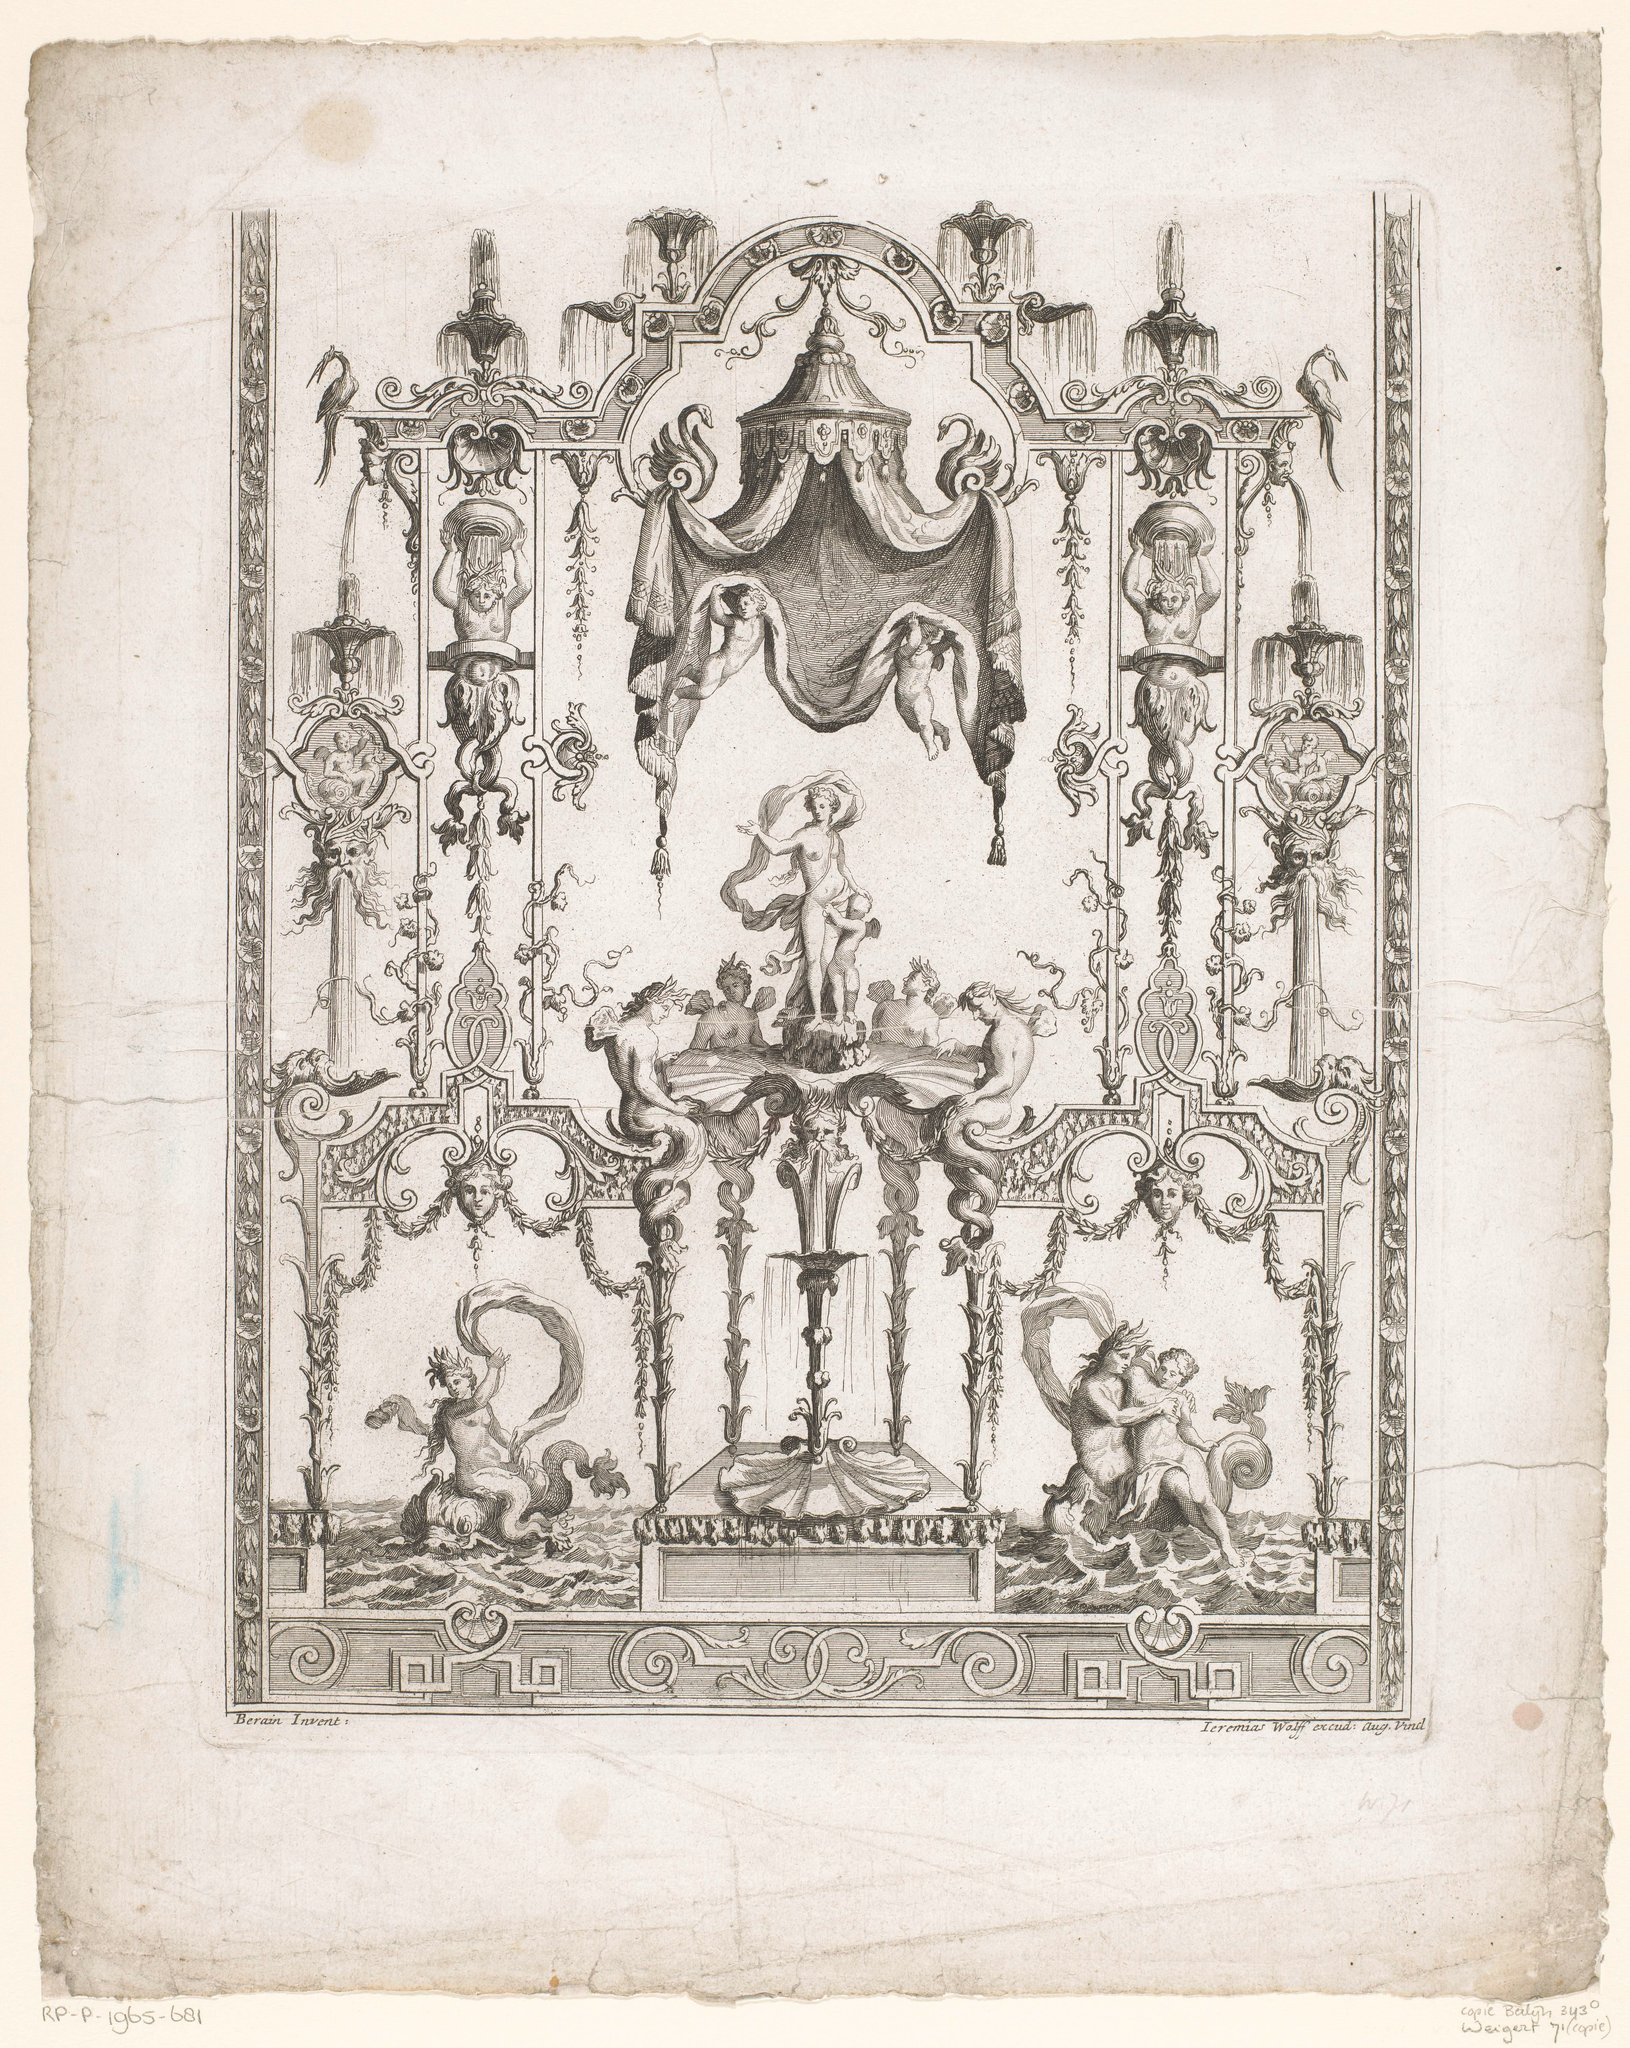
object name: ornament print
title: Compositie met Venus Anadyomene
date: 1686-1724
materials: paper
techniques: etching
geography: augsburg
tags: frequently used ornamental compositions, birth of venus; venus anadyomene: after uranus' castration venus rises from the sea wringing the water from her hair; usually she is awaited by the hours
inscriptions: collector's mark: Lugt 2228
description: Een decoratieve compositie met fonteinen en in het midden Venus Anadyomene op een schelp onder een baldakijn. Rondom de schelp meerminnen. Links- en rechts onder zitten een meermin en een meerman met een vrouw op dolfijnen.